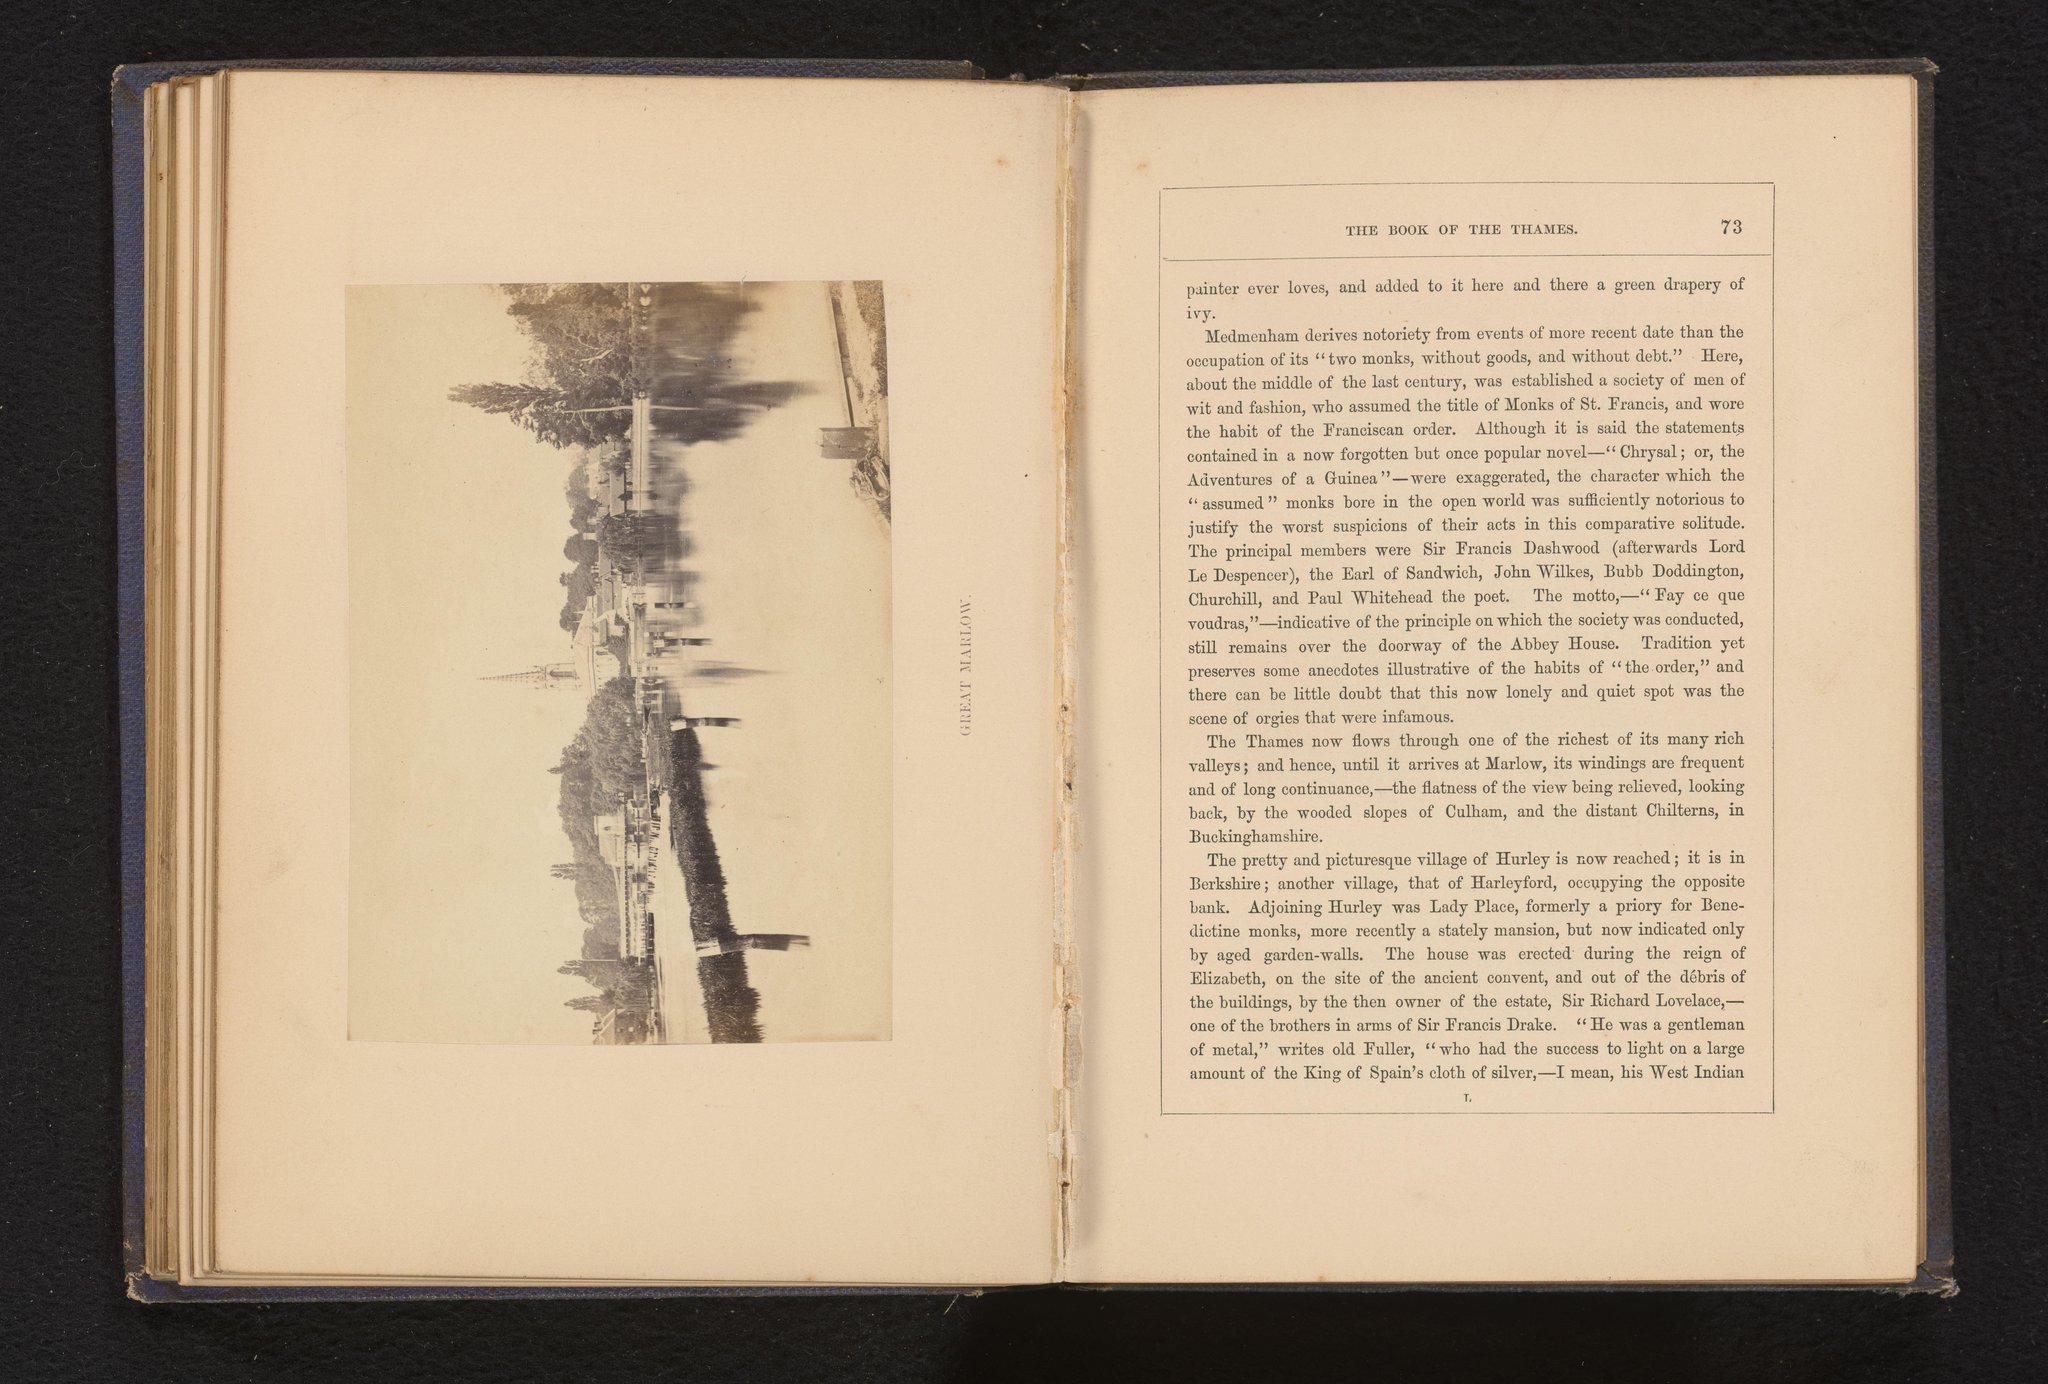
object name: page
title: Great Marlow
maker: francis frith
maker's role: publisher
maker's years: 1822-1898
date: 1862-1867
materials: paper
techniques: albumen print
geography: marlow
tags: river, thames